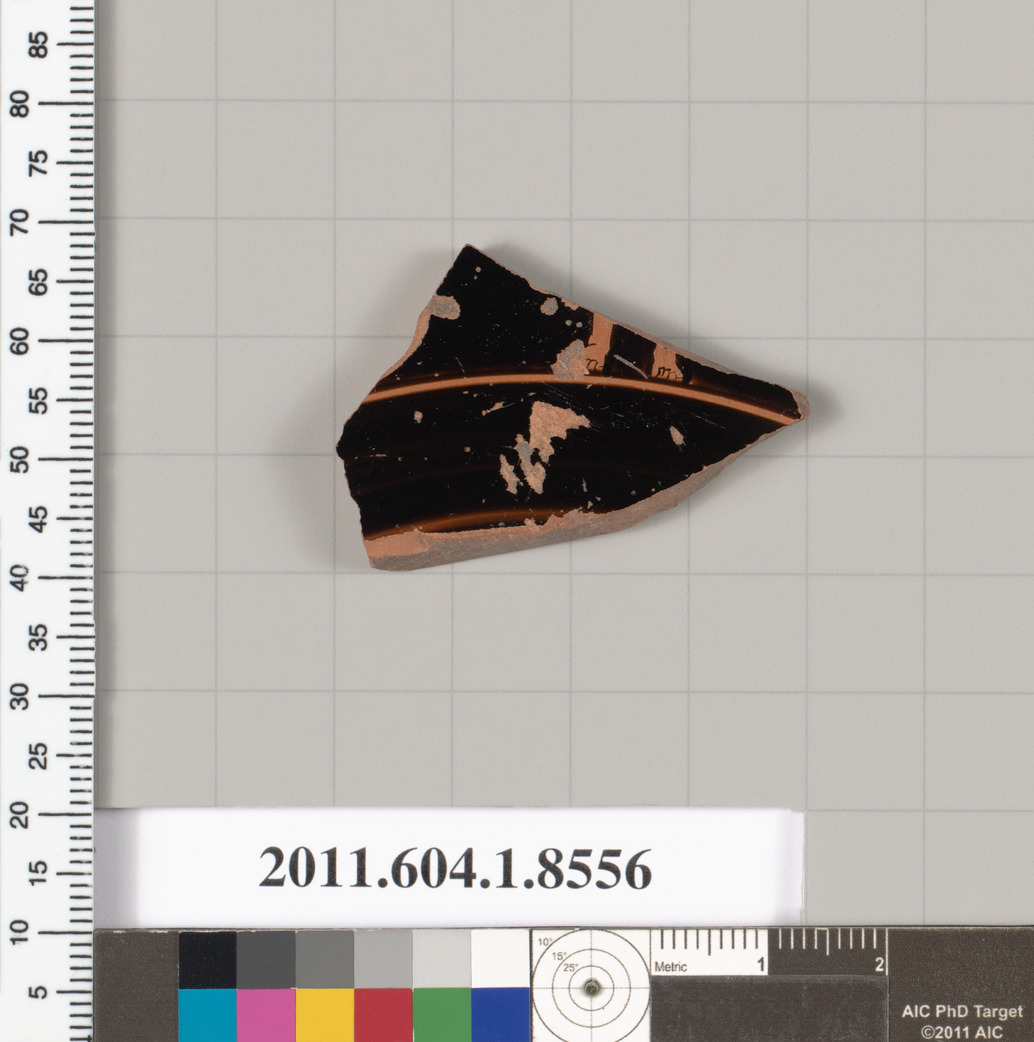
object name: kylix fragment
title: Terracotta fragment of a stemless kylix (drinking cup)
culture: greek, attic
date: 470-450 BCE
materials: terracotta